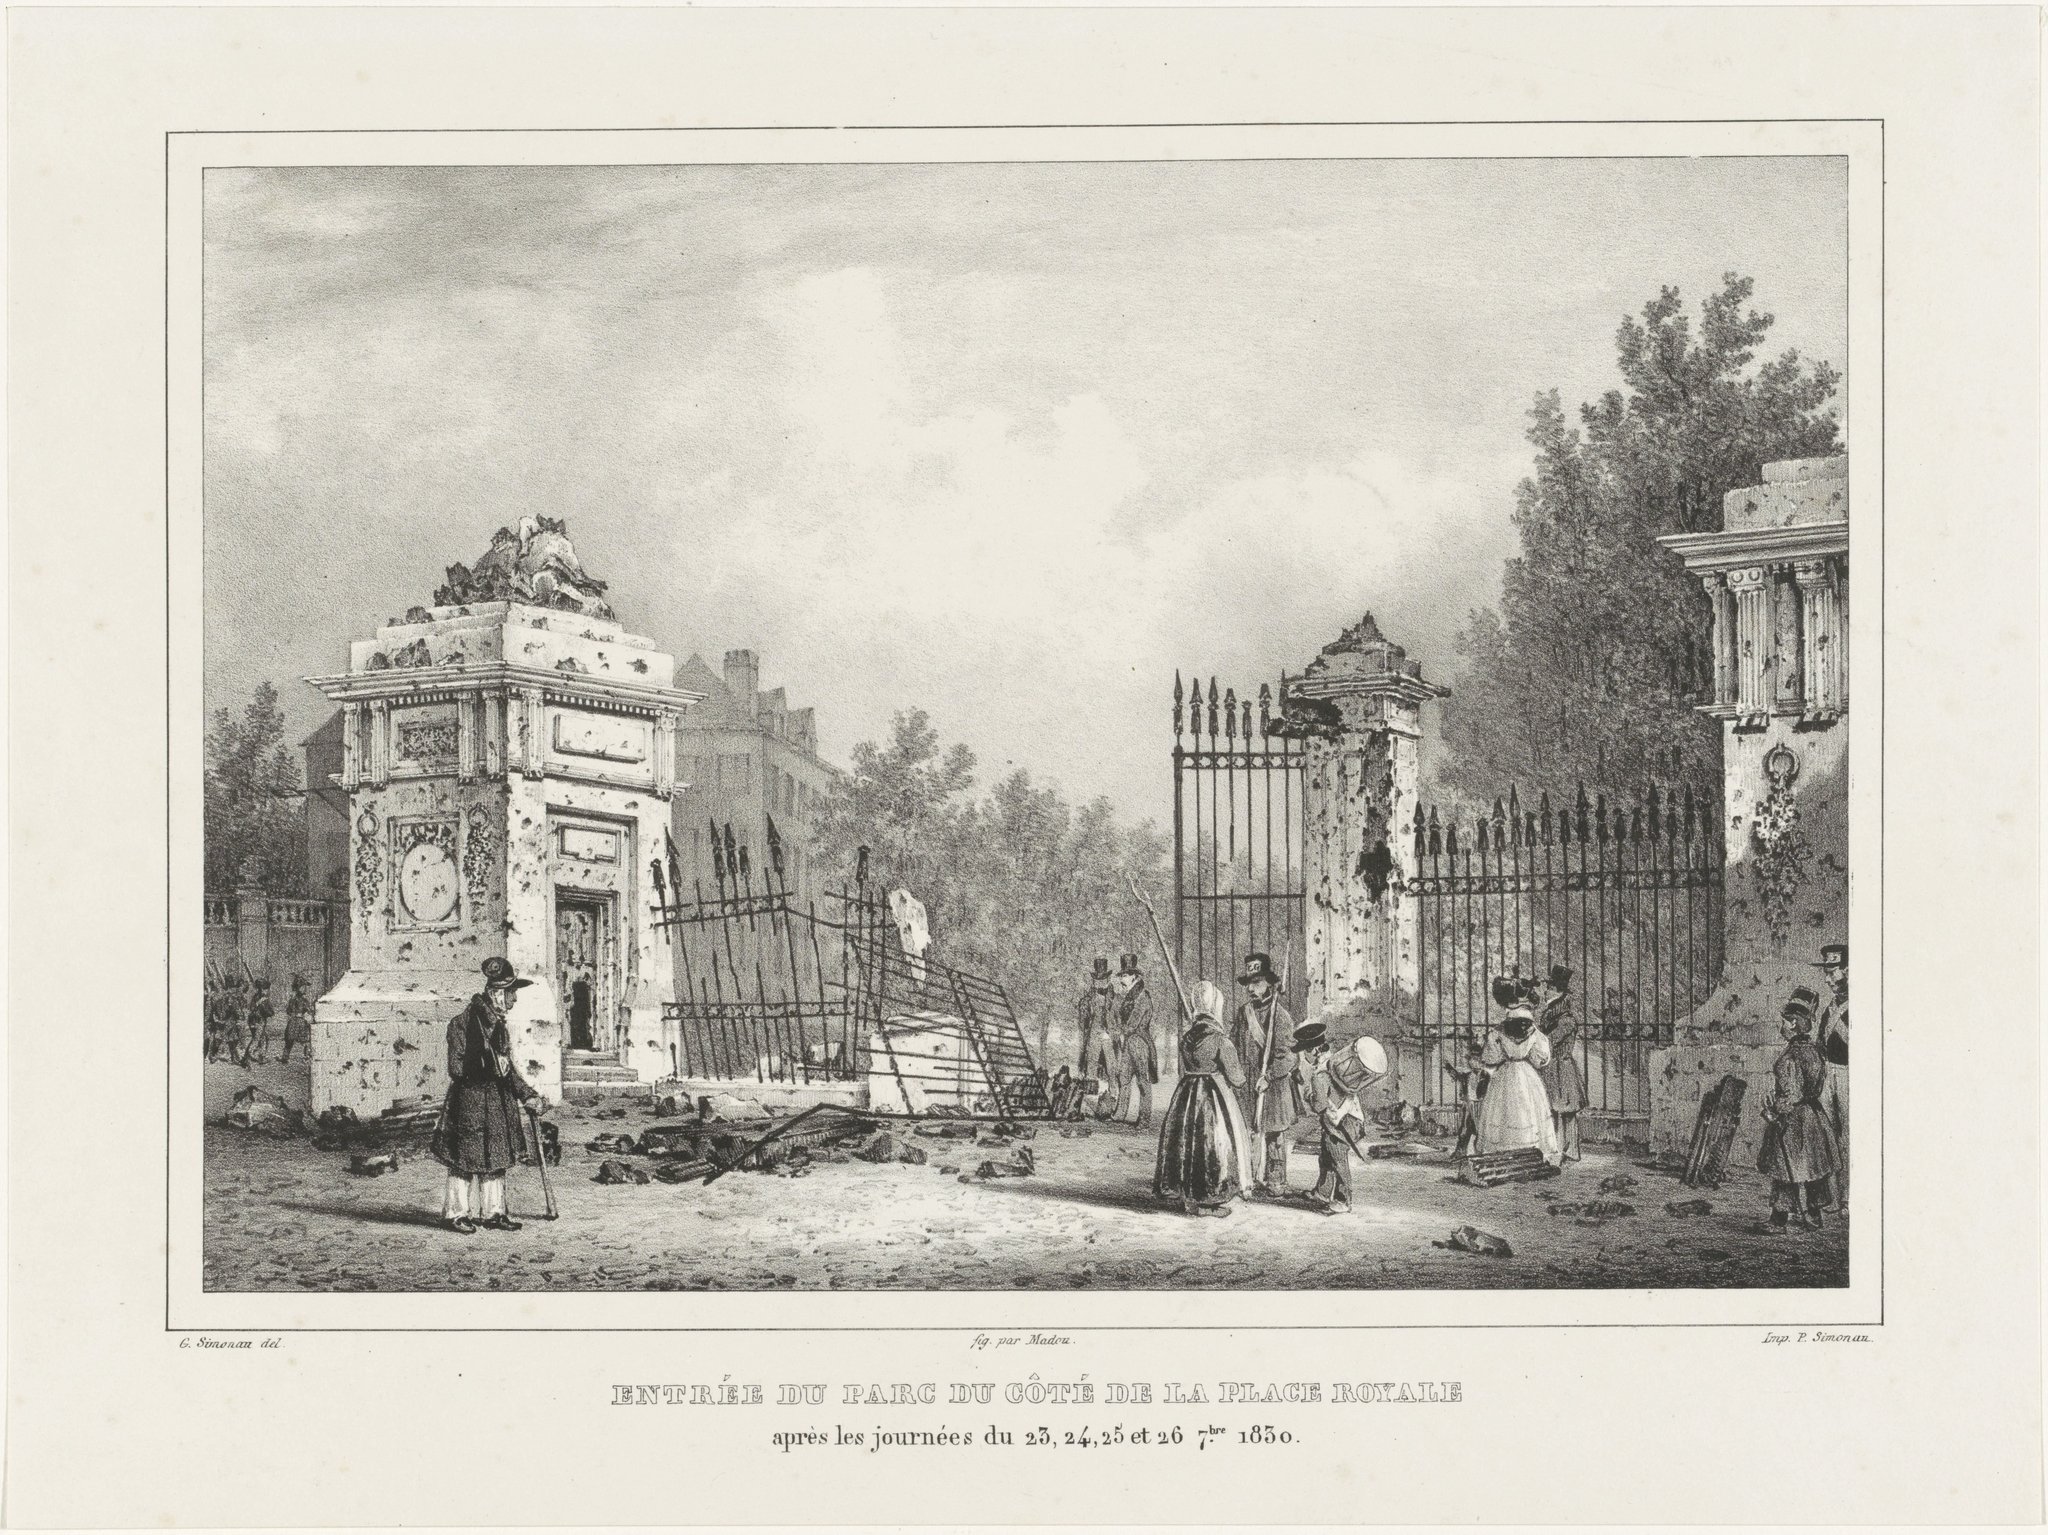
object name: print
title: Entrée du Parc du côté de la Place Royale après les journées du 23, 24, 25 et 26 7.bre 1830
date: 1830-1831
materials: paper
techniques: lithograph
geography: brussels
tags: devastated, ruined place or city (~ warfare), street-fights, riots, brussels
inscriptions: collector's mark: Lugt 2228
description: De verwoeste toegangspoort van het Warandepark te Brussel, na de gevechten 23-26 september 1830. Onderdeel van een serie van zes platen van de gevechten in Brussel in september.